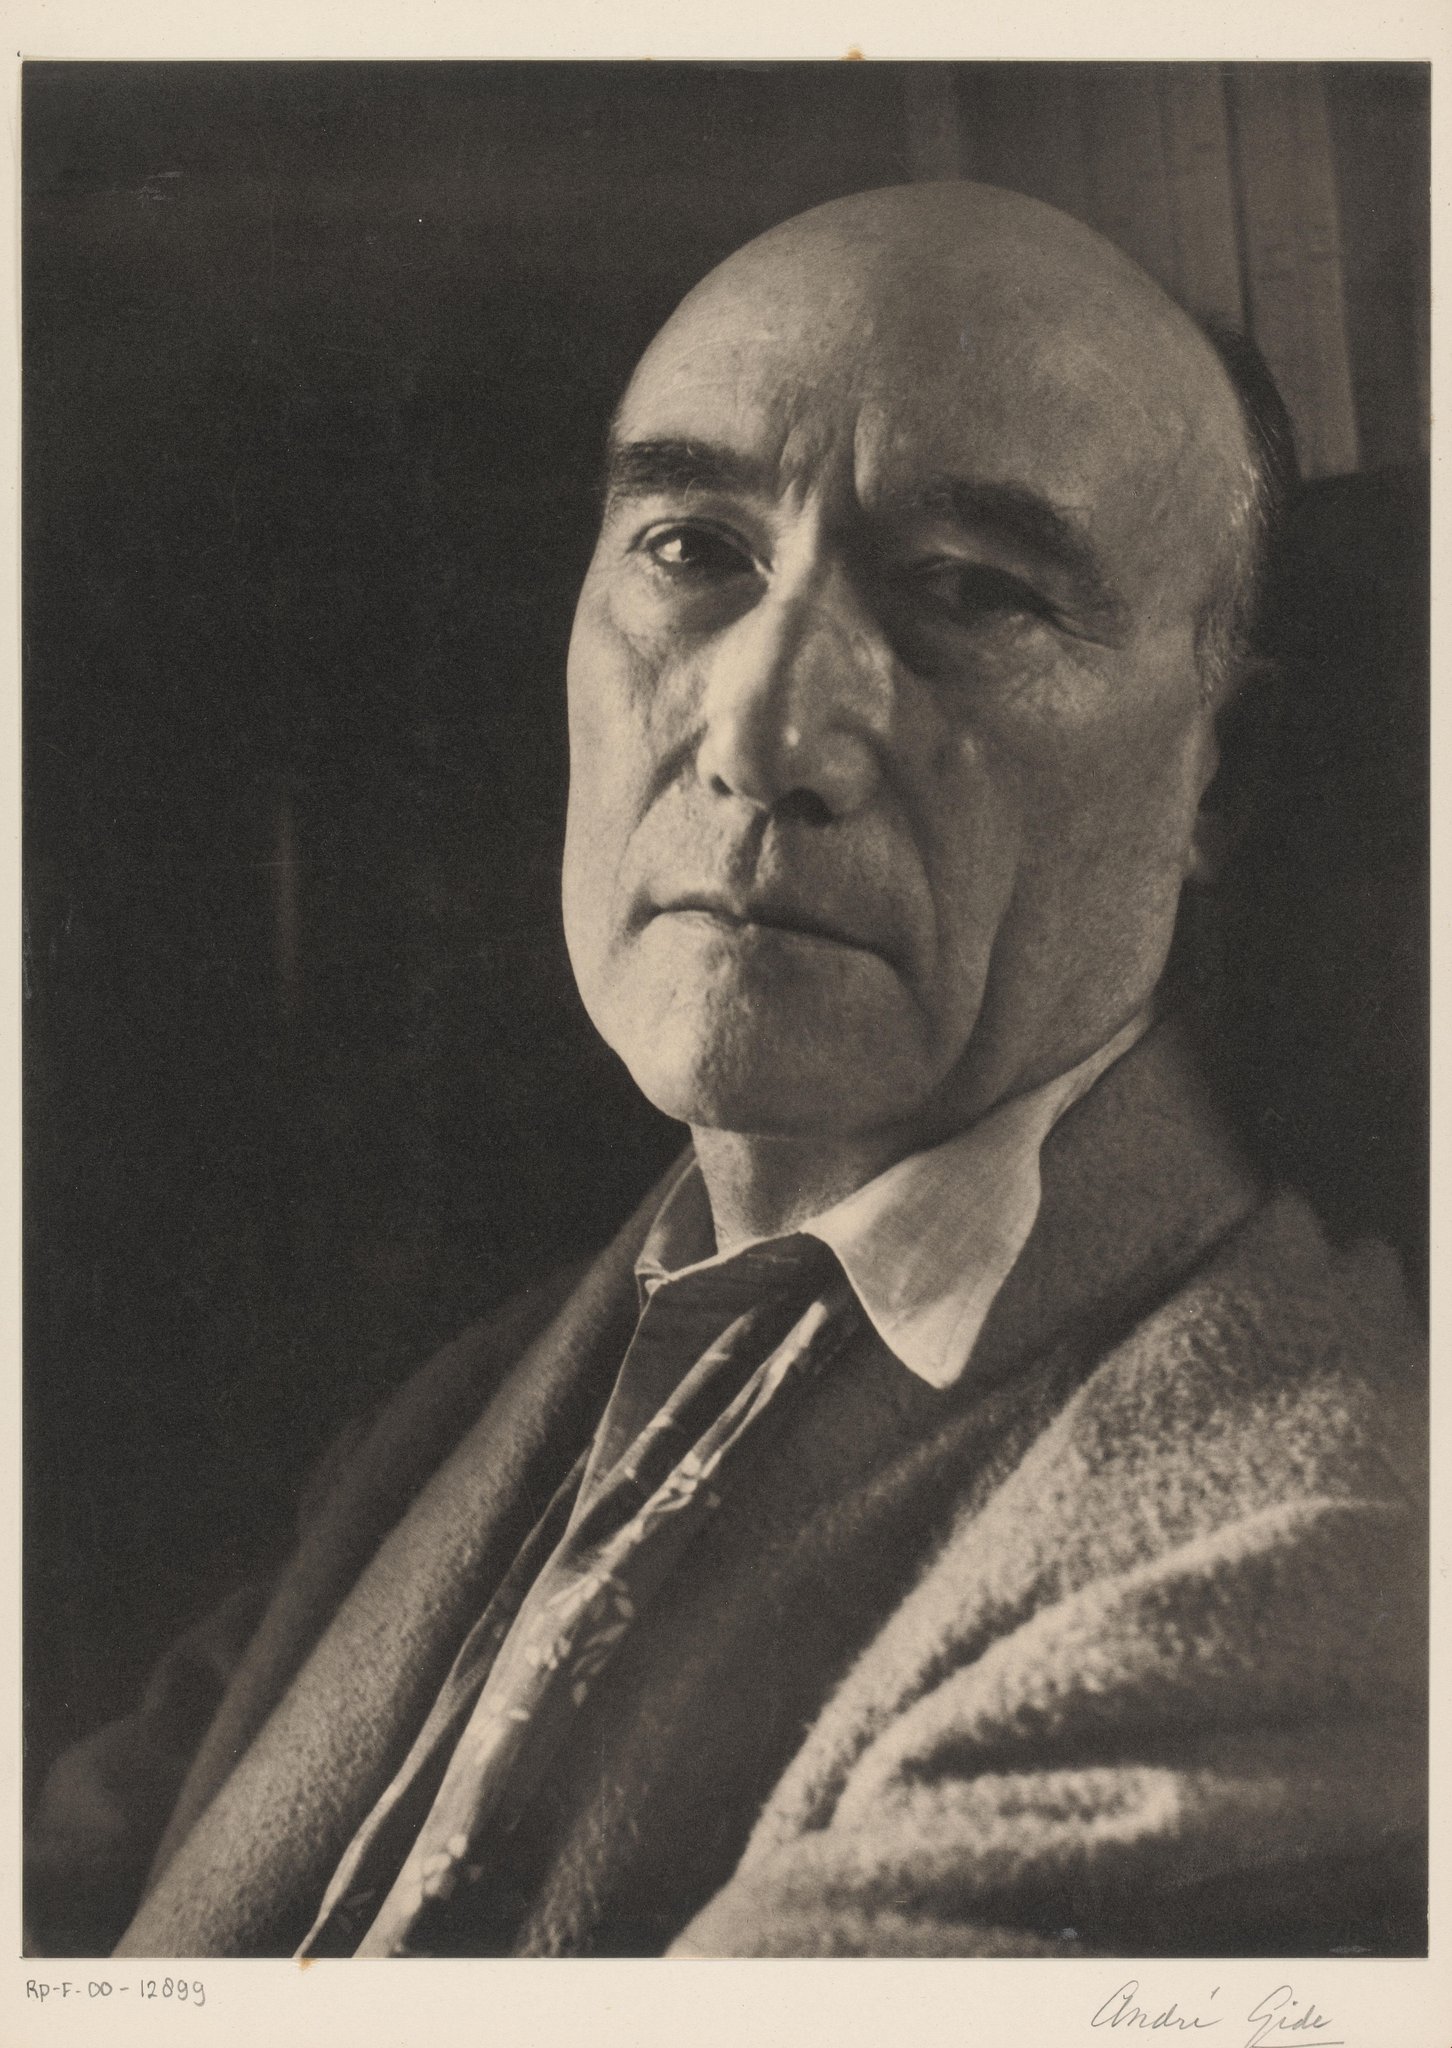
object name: photograph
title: Portret van André Gide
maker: charles leirens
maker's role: fotograaf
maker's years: 1888-1963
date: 1936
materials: paper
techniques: gelatin silver print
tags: paris, writer, poet, author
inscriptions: copyright notice: ‘ANDRÉ GIDE/ Charles Leirens: "20 Portraits d'Artistes" No 1/ Copyright Editions de la Connaissance,/ Bruxelles 1936.’